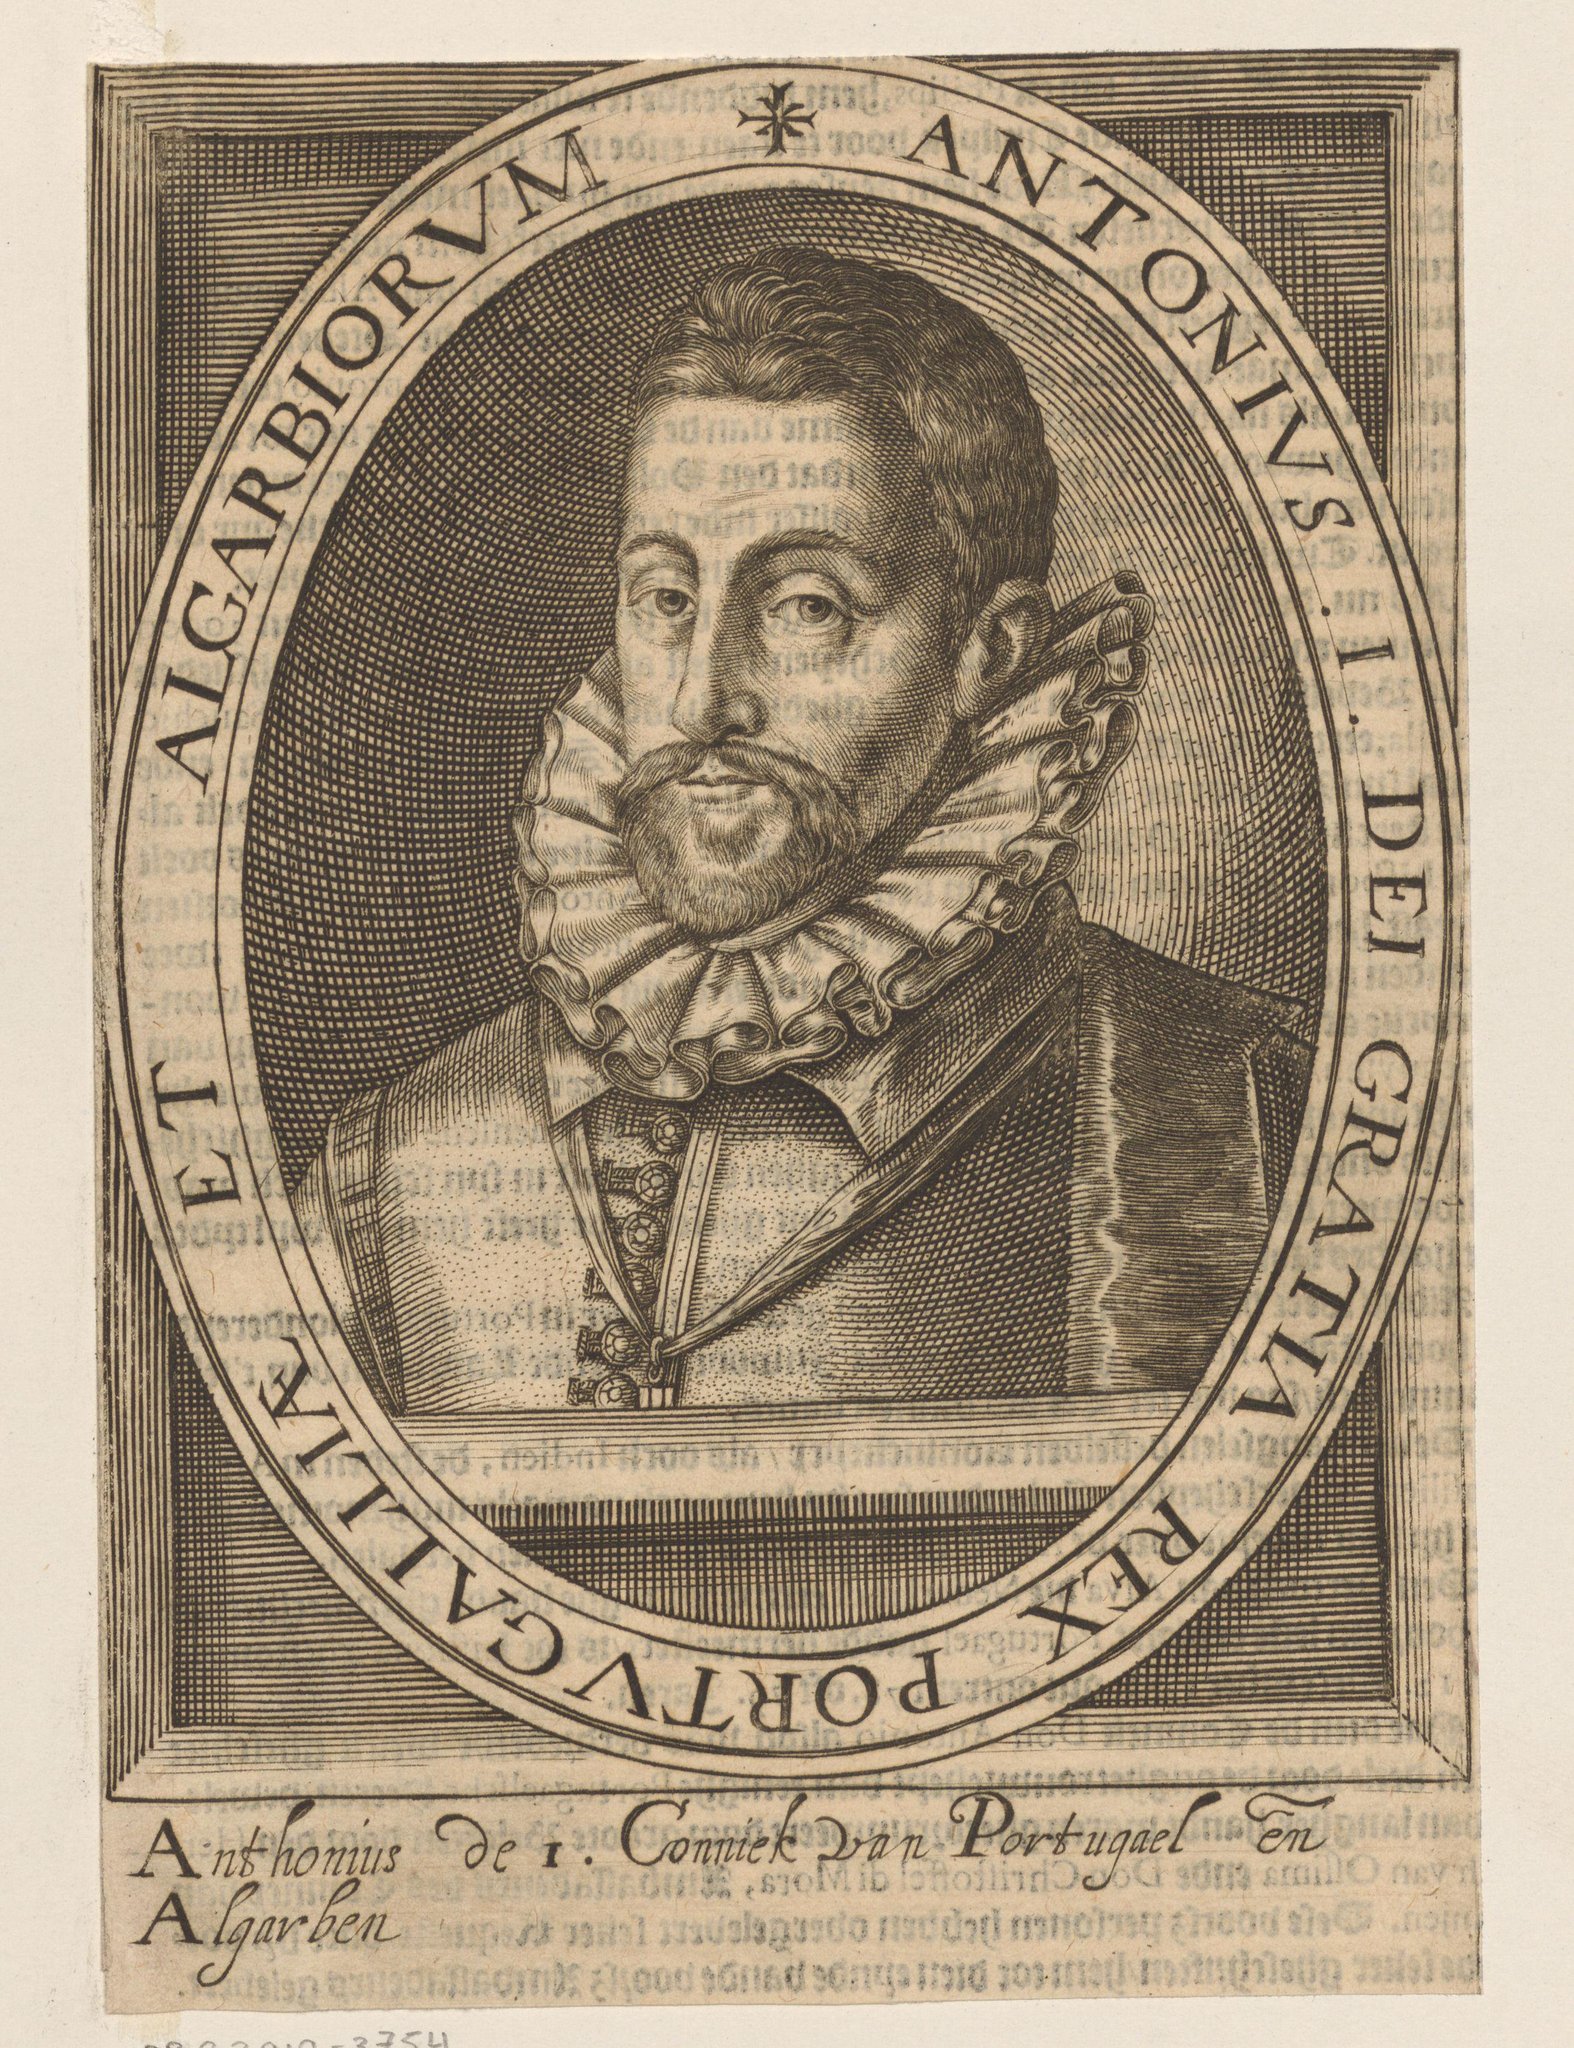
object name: print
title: Portret van Anton I, koning van Portugal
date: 1615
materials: paper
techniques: engraving, letterpress printing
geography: delft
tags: paris, historical persons, ruler, sovereign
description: Prent uit: Clerck, Nicolaes de. Tooneel der keyseren en[de] coningen van christenryck sedert den onderganck van het Griecks keyserdom. Delft: Nicolaes de Clerck, 1615, p. 114.